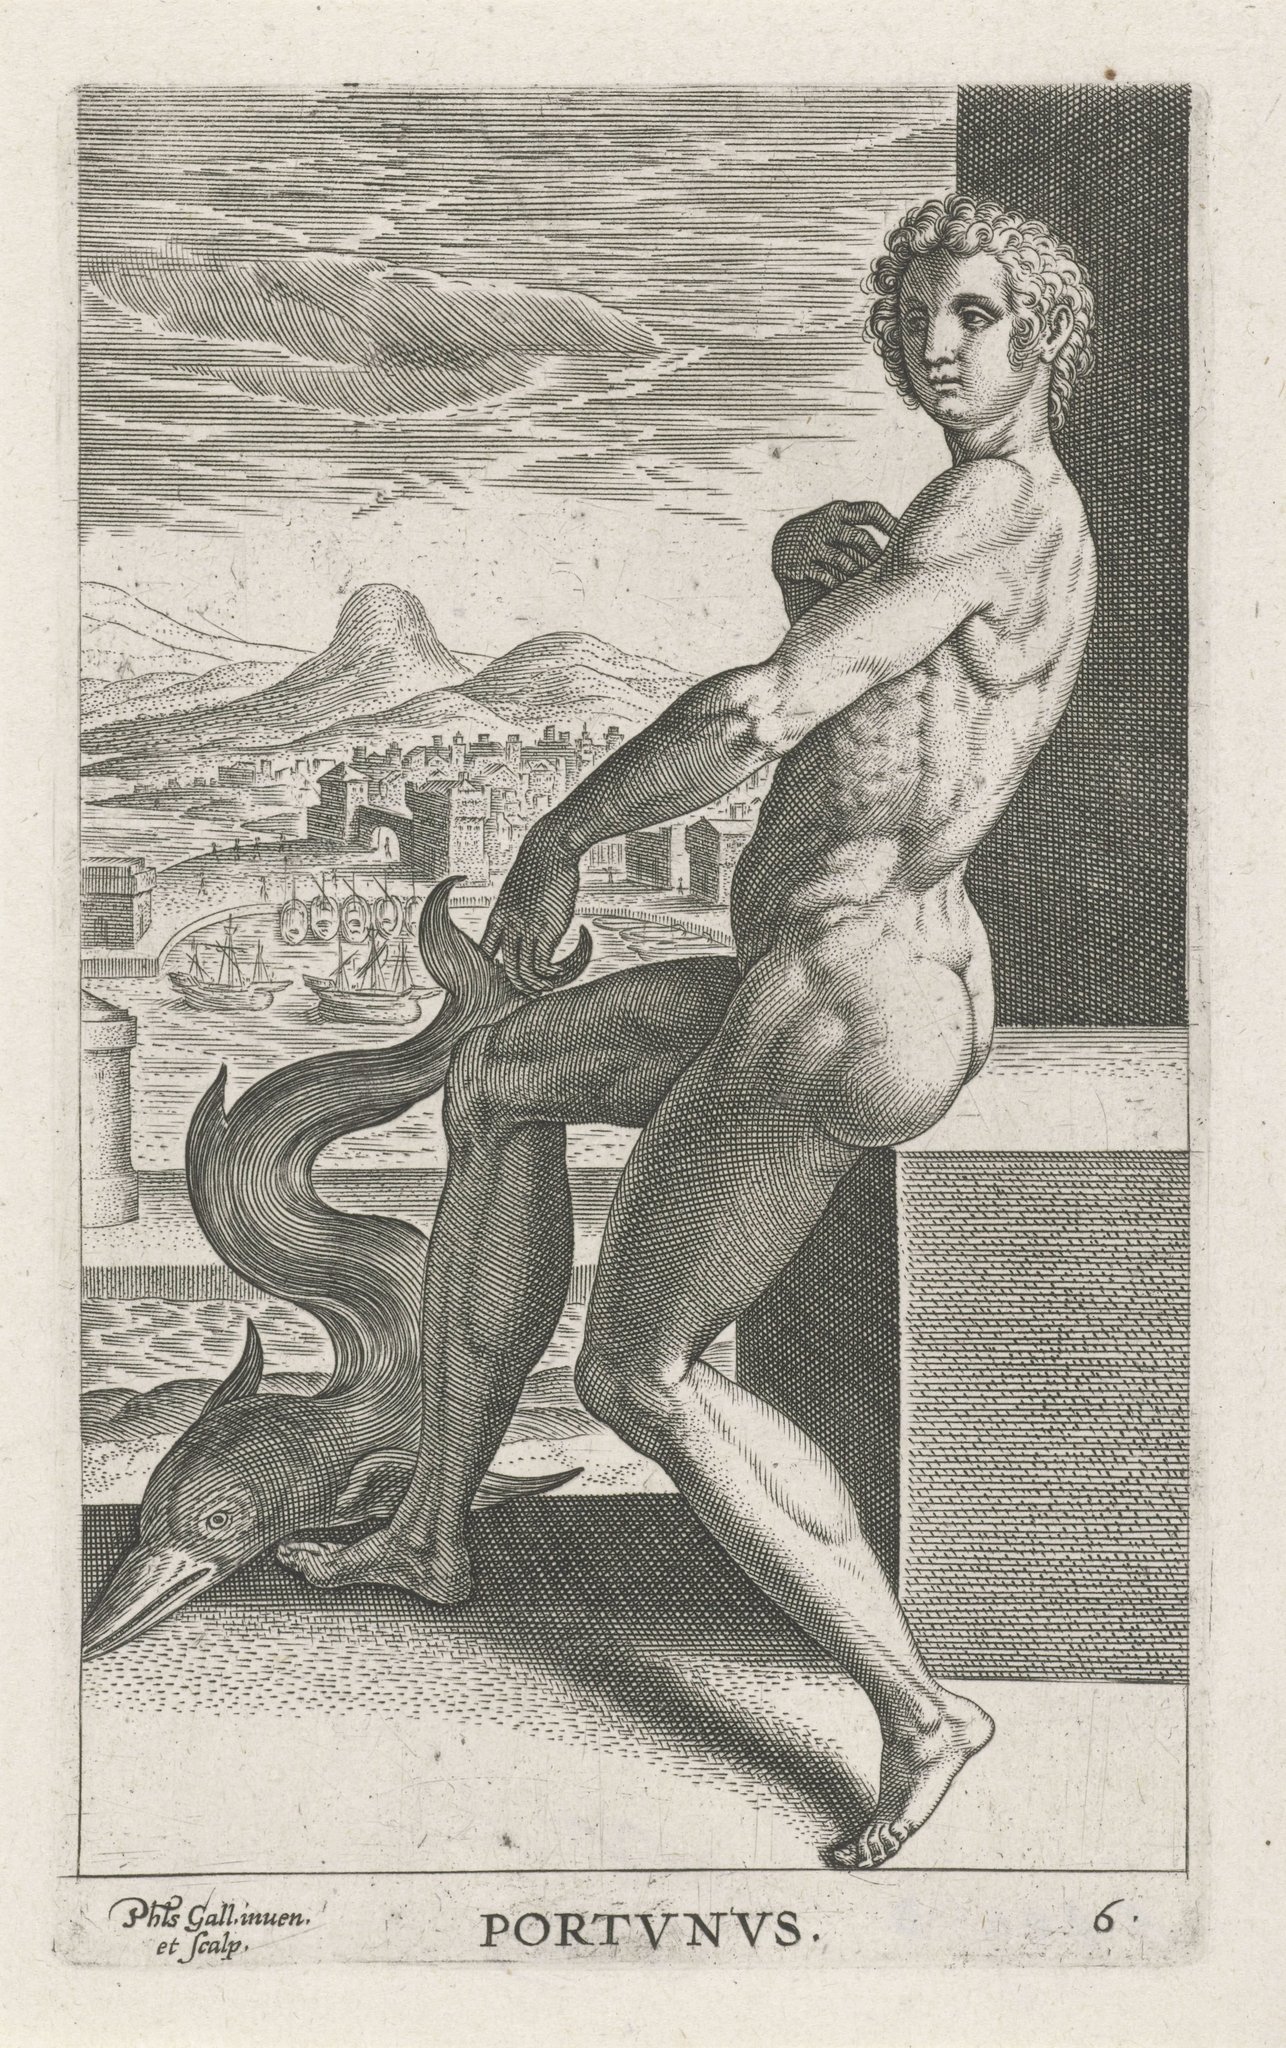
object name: print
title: Zeegod Portunus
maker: philips galle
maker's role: print maker, publisher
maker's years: 1537-1612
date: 1586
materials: paper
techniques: engraving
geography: antwerp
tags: (story of) palaemon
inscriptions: collector's mark: Lugt 2228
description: De zeegod Portunus, gezeten op een steen. De prent maakt deel uit van een zeventiendelige serie over rivier- en zeegoden.